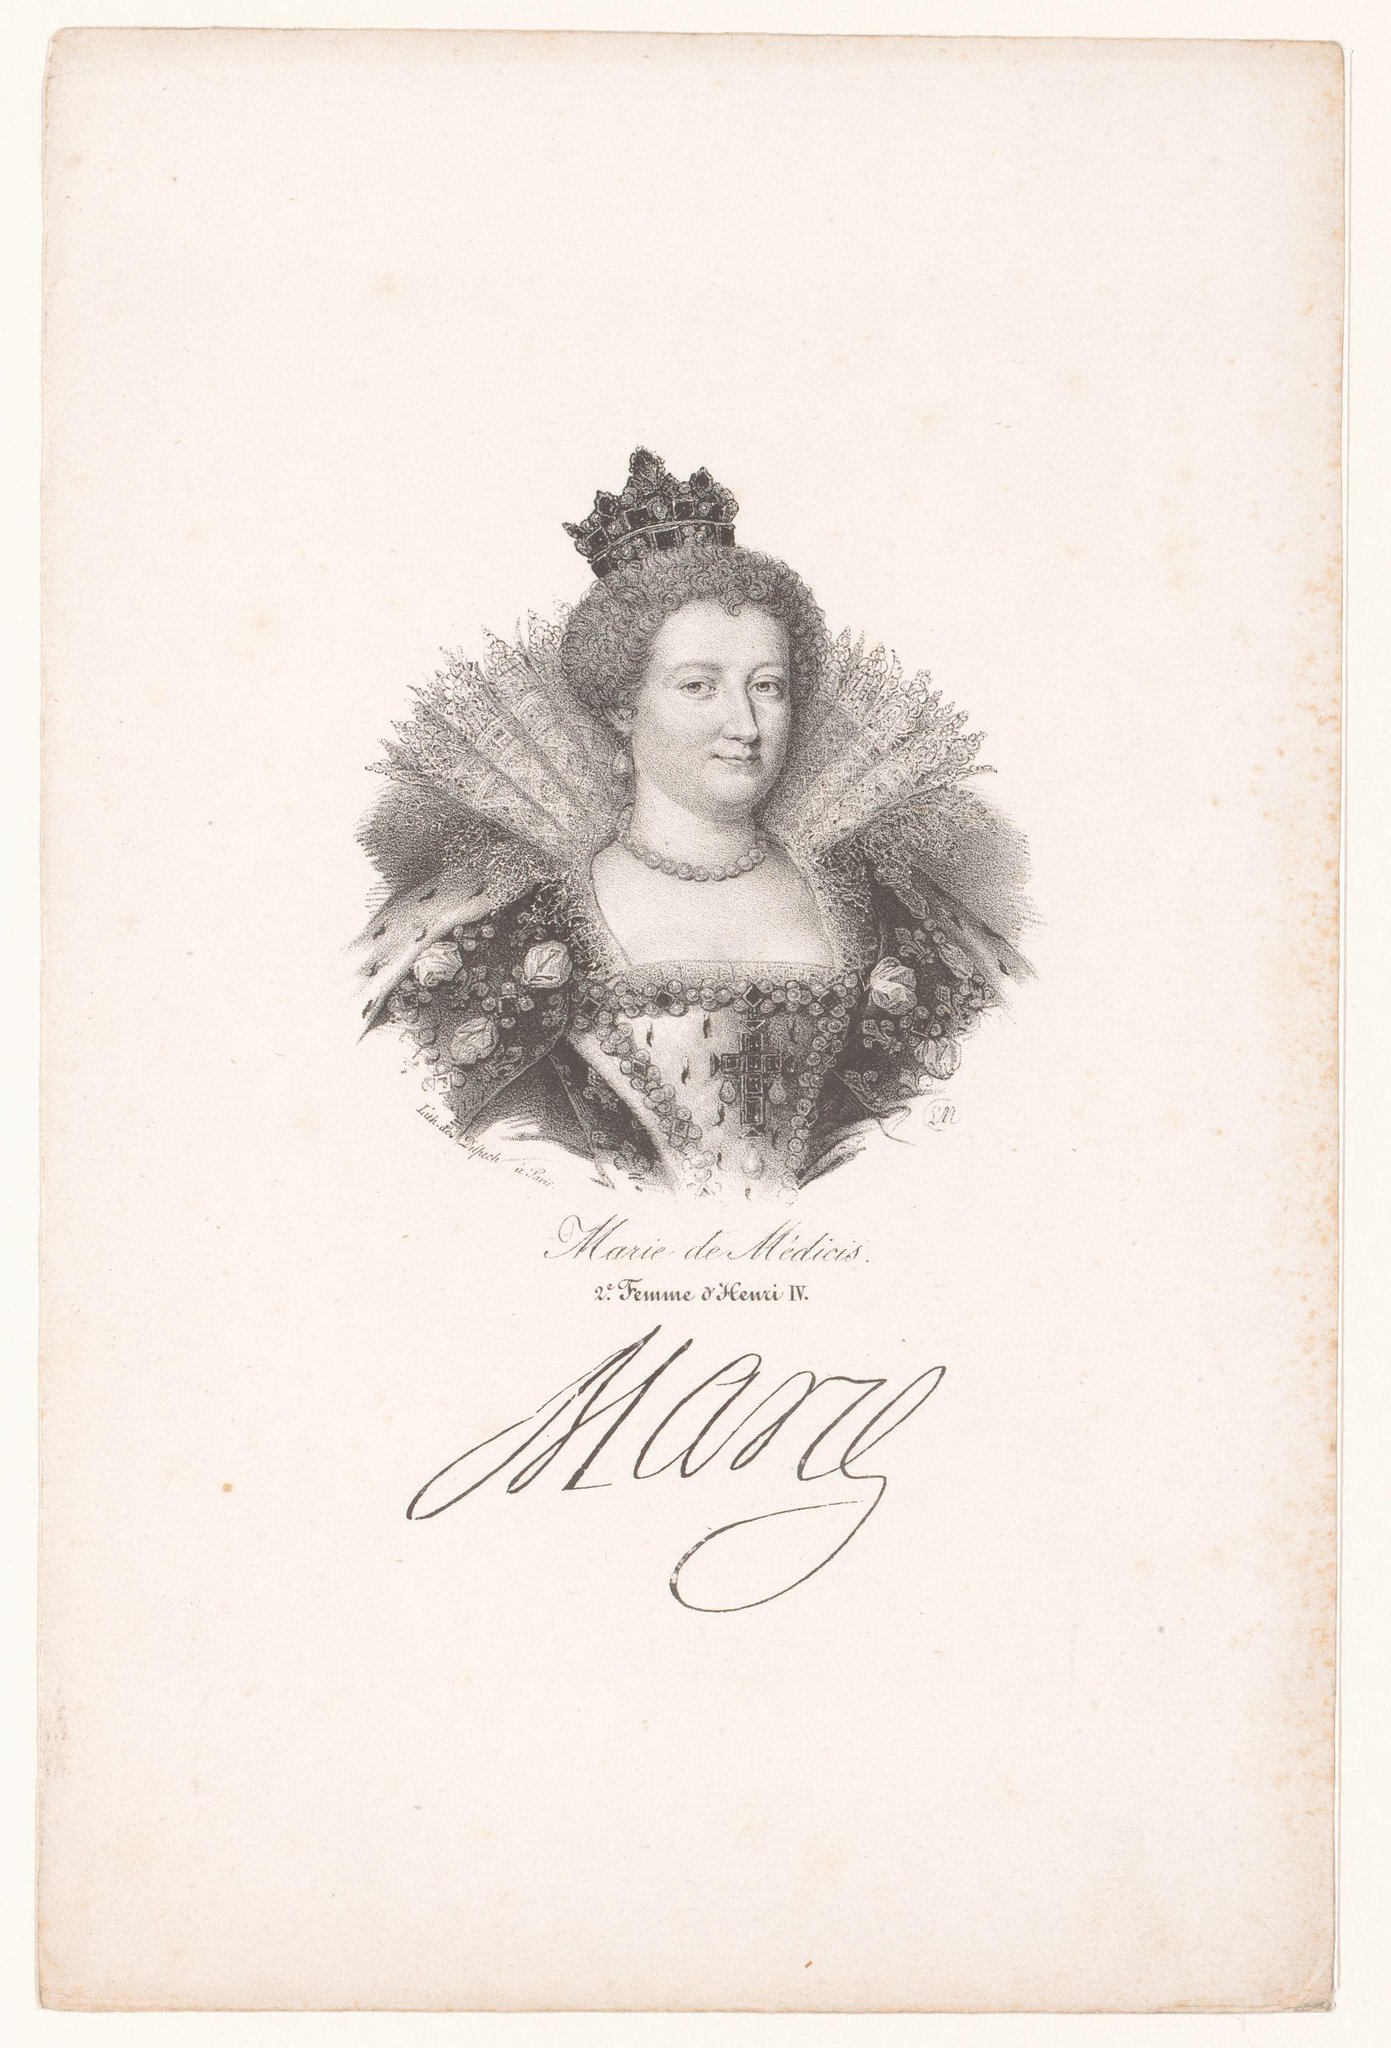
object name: print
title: Marie de Médicis, 2e. femme d'Henri IV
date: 1825-1842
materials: paper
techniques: lithograph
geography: paris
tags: print maker, maria de' medici, historical persons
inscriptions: collector's mark: Lugt 2228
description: Prent waarschijnlijk gebruikt voor: Rois et reines de France: depuis l'origine de la monarchie jusqu'à nos jours. 3 dln. Parijs: veuve Delpech, 1833-1840. En/of voor: Iconographie française ou recueil des portraits des personnages les plus illustres qui ont paru en France depuis François premier jusqu'à la fin du règne de Louis XVI (…). Parijs: veuve Delpech, 1828. En/of voor: Iconographie française ou choix de deux cents portraits d'hommes et de femmes qui se sont acquis en France, depuis le règne de Charles VII jusqu'à la fin de celui de Louis XVI (…). Parijs: veuve Delpech, 1840. Mogelijk komt de prent ook voor in eerdere en/of latere publicaties uitgegeven door veuve Delpech of haar opvolger Rosselin.